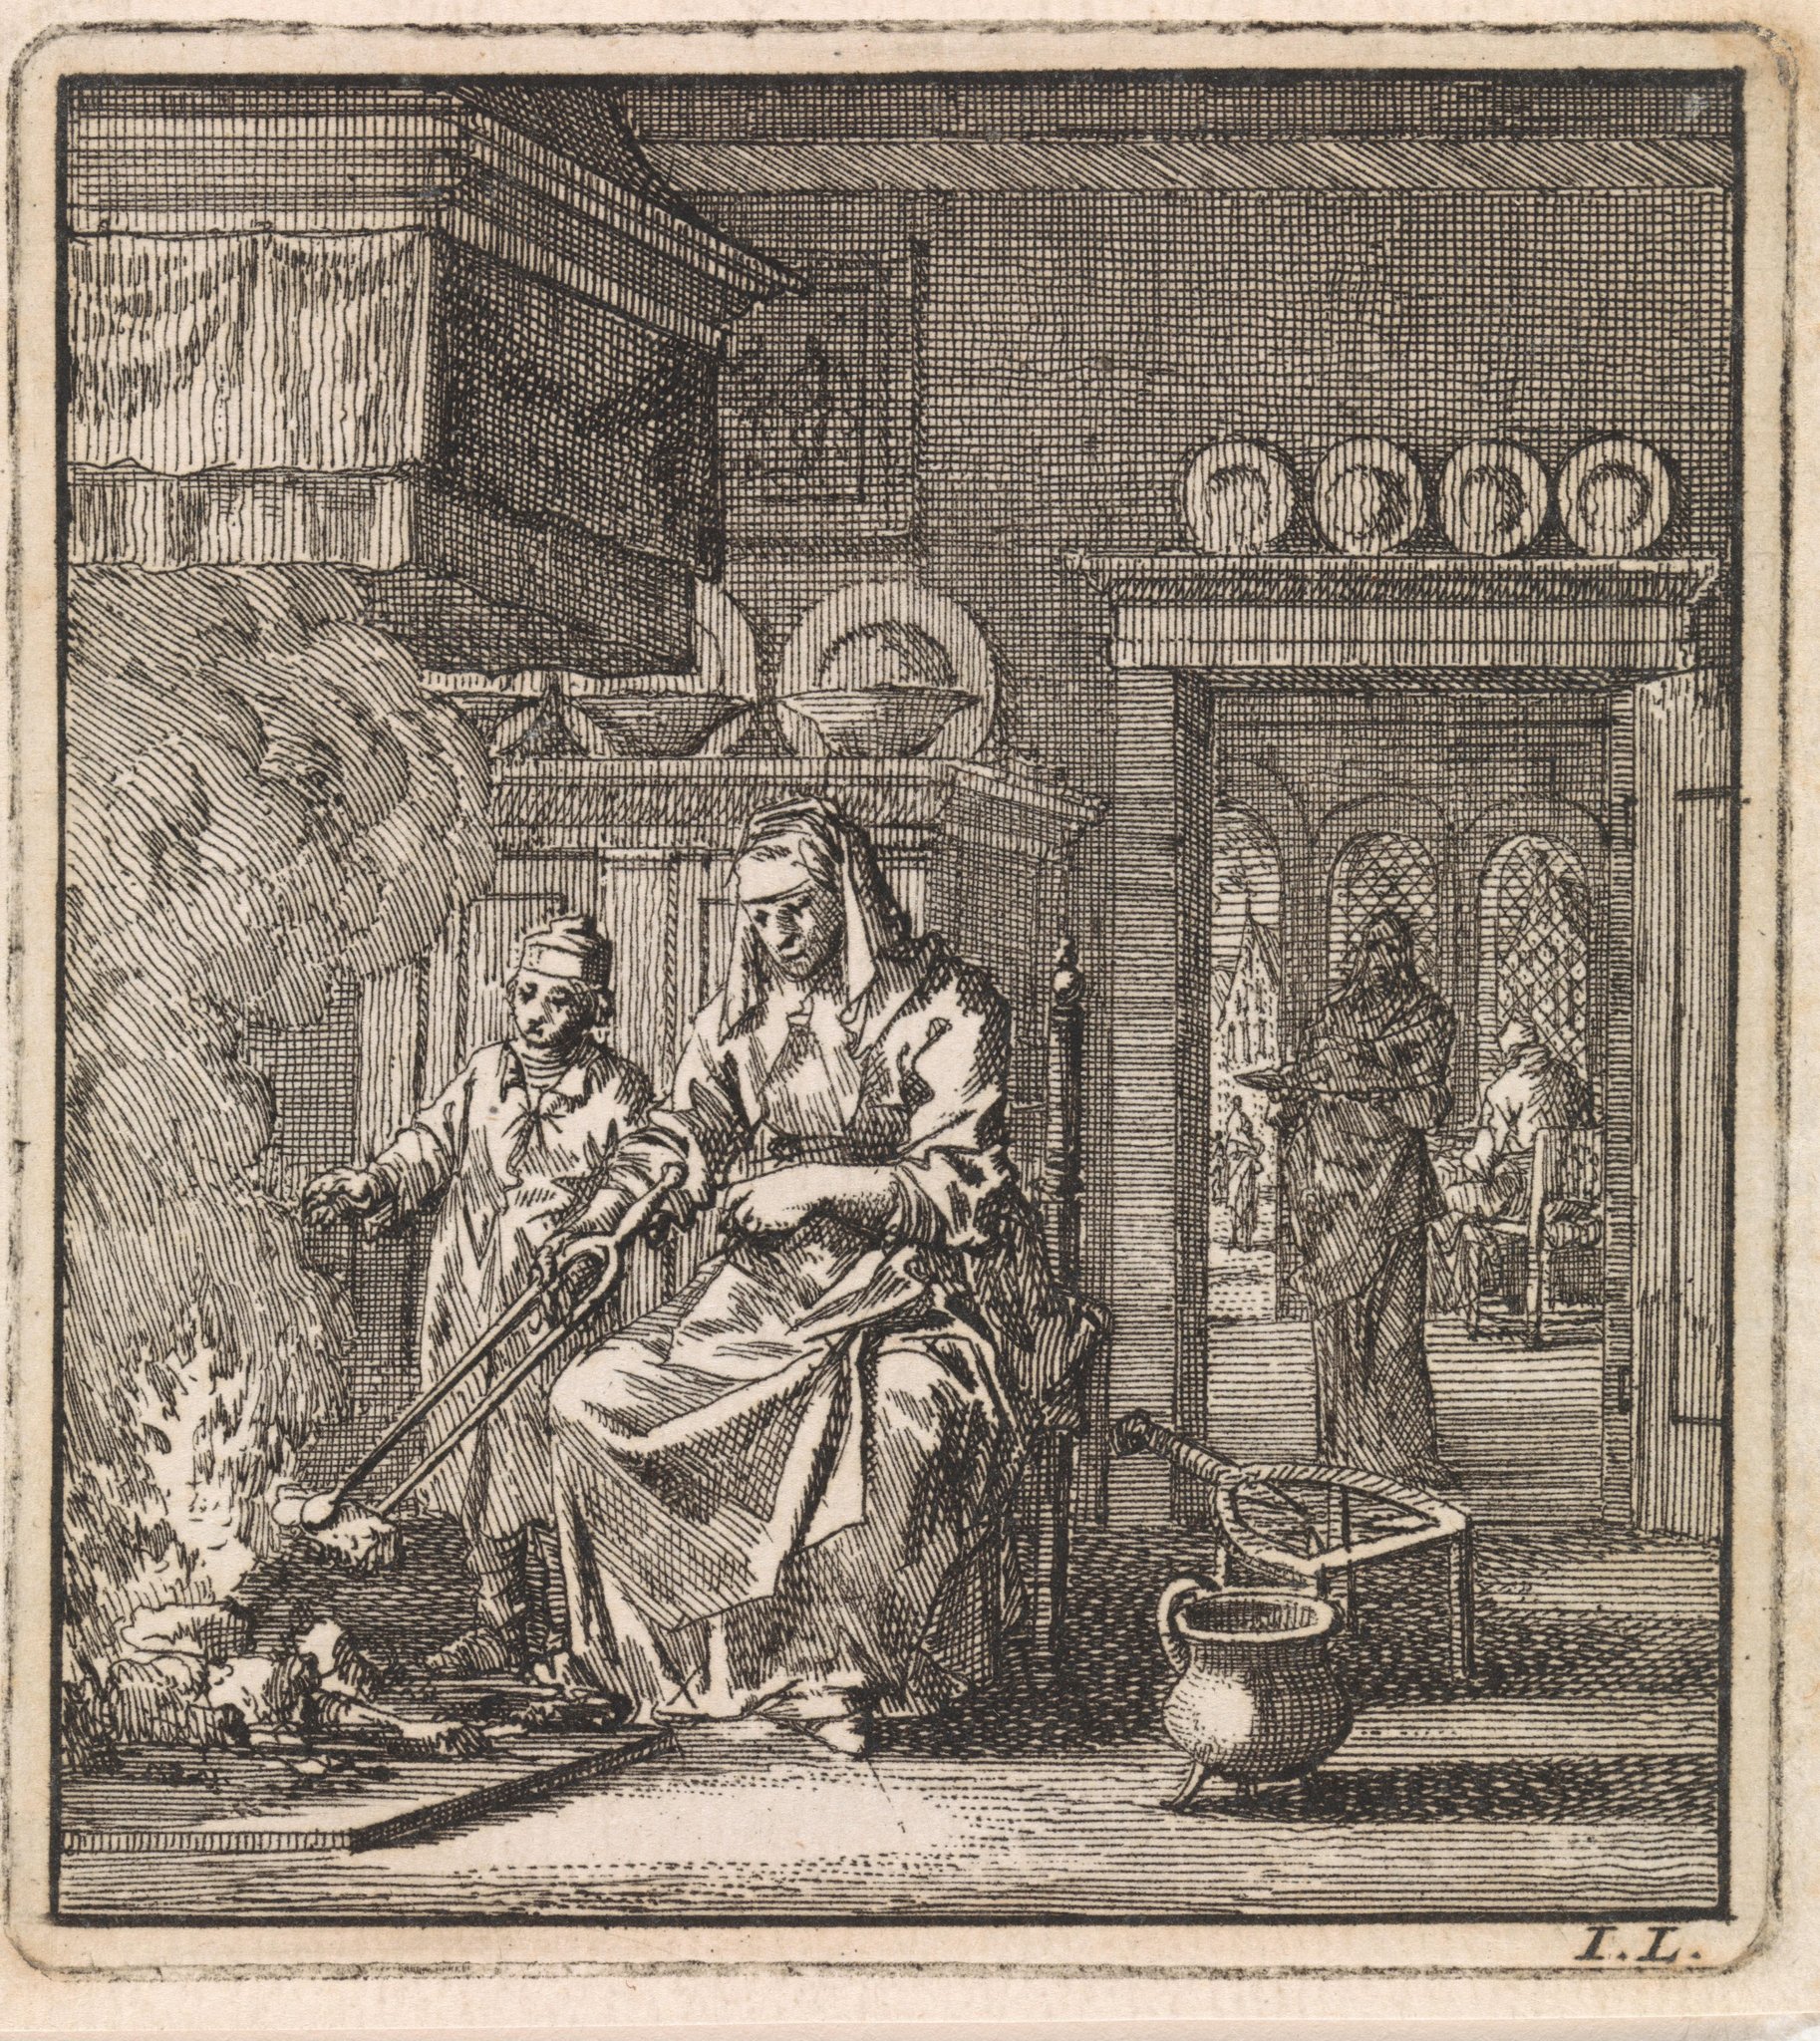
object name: print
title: Vrouw legt met een tang turf in het haardvuur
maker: jan luyken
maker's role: draughtsman, print maker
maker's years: 1649-1712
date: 1711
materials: paper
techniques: etching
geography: amsterdam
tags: chimney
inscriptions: collector's mark: Lugt 2228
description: Illustratie voor: Luyken, Jan. Het leerzaam huisraad, vertoond in vyftig konstige figuuren, met godlyke spreuken en stichtelyke verzen: Pieter Arentsz. II (wed.) en Cornelis van der Sys, 1711, p. 16.